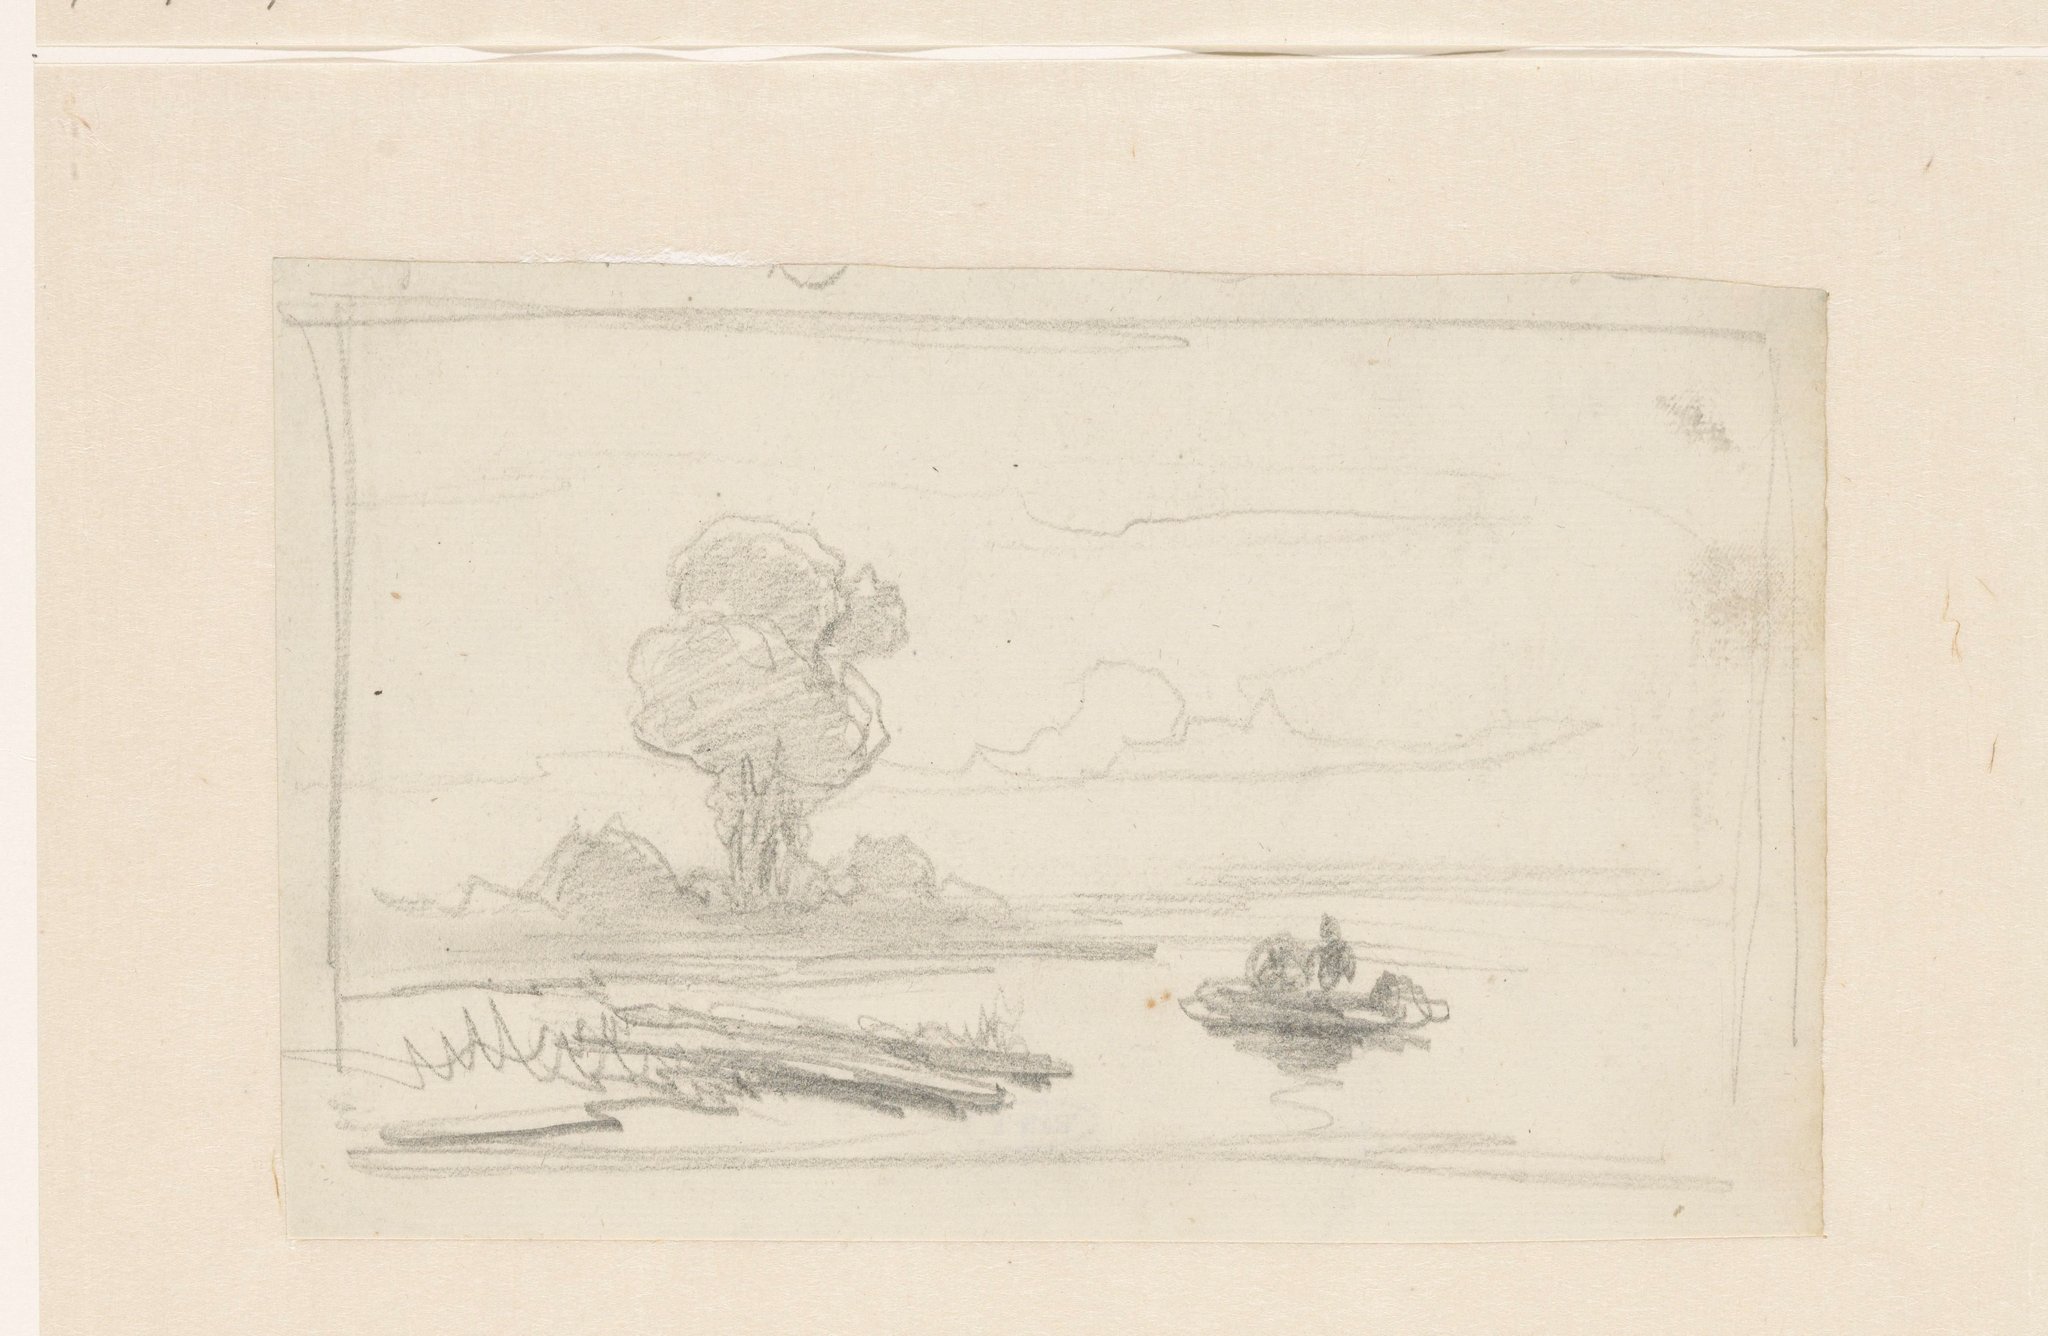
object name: drawing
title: Schets van een boot op het water, op de achtergrond een hoge boom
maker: andreas schelfhout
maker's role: draughtsman, painter, print maker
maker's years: 1787-1870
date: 1797-1870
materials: paper, pencil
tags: river, rowing-boat, canoe, etc.